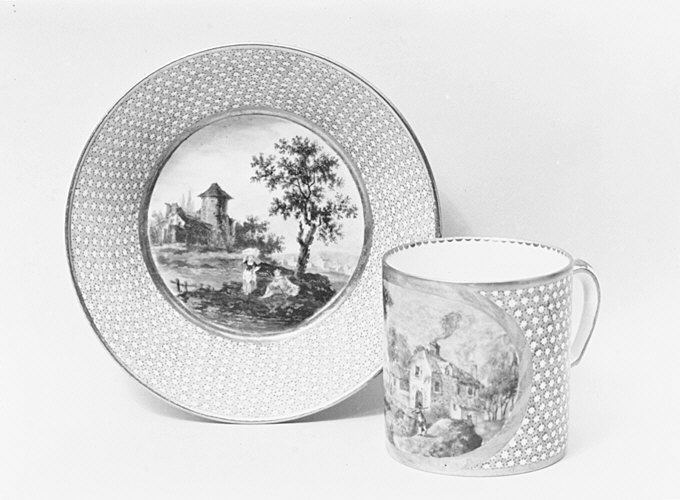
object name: cup and saucer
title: Cup and saucer (gobelet litron et soucoupe)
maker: sèvres manufactory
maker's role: manufactory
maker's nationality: french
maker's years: 1740-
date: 1772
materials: soft paste porcelain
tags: human figures,buildings,trees